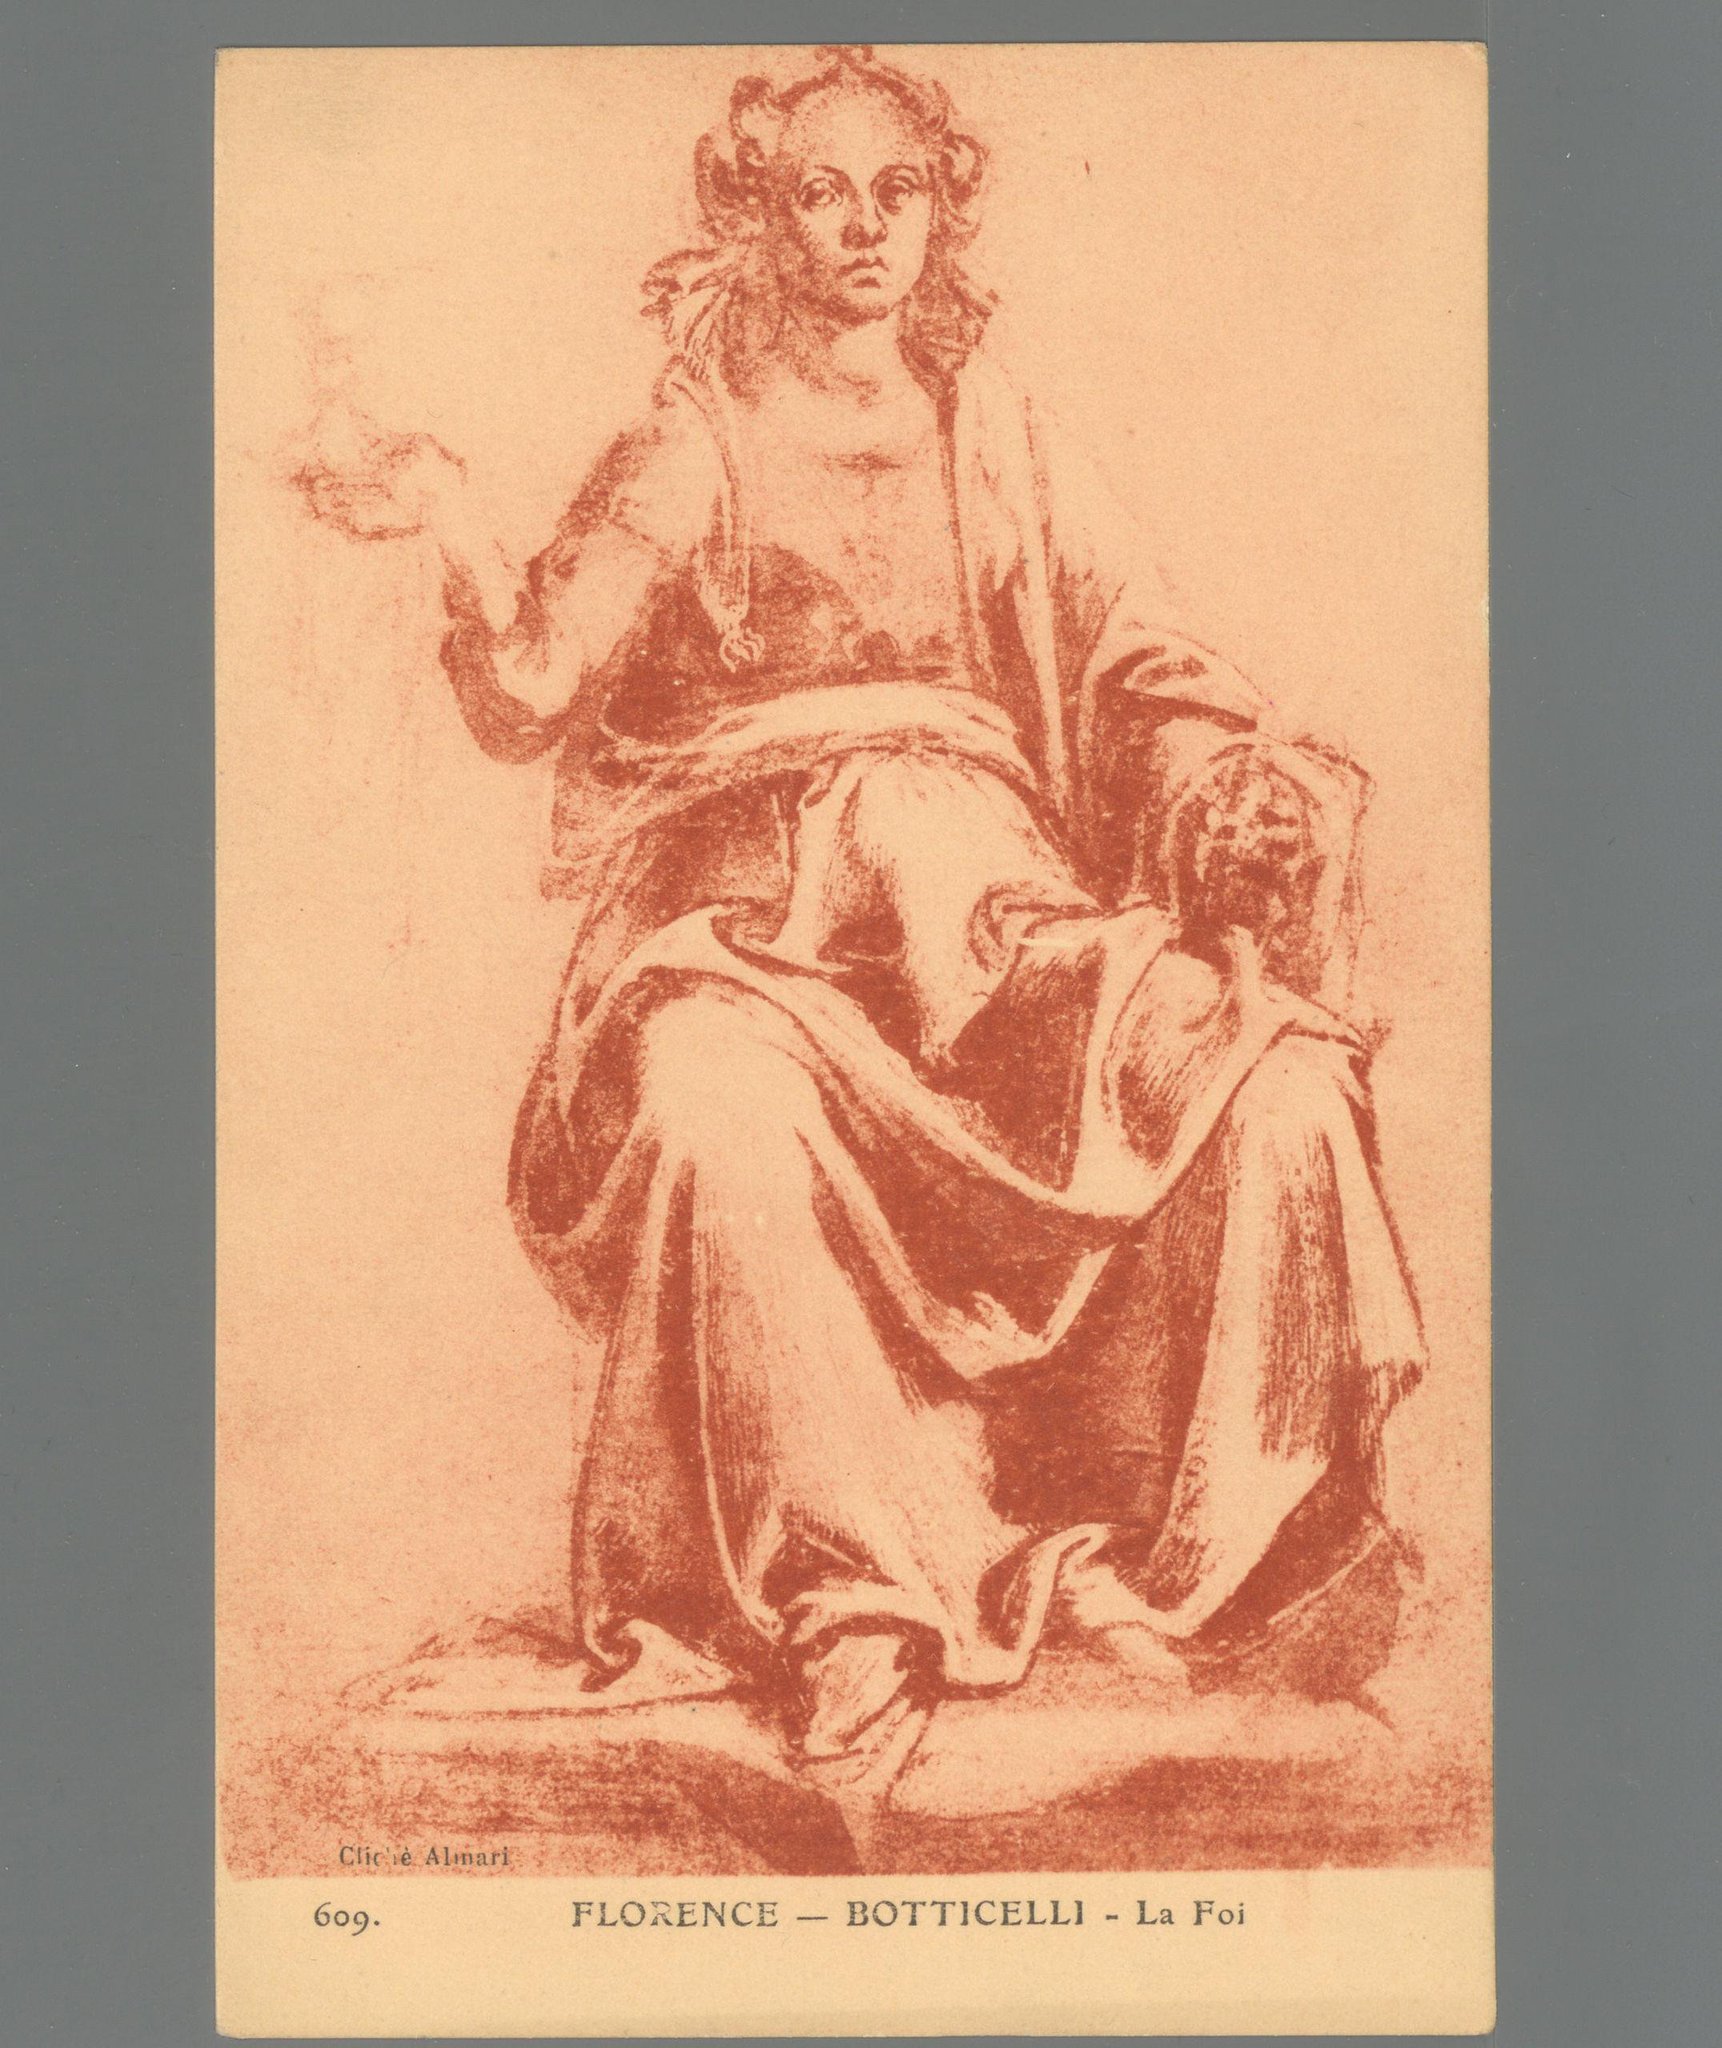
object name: ansichtkaart, prentbriefkaart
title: Florence - Botticelli - La Foi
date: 1903-1925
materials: cardboard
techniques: photograph, writing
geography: paris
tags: picture, painting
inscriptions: collector's mark: ‘AFE v S’